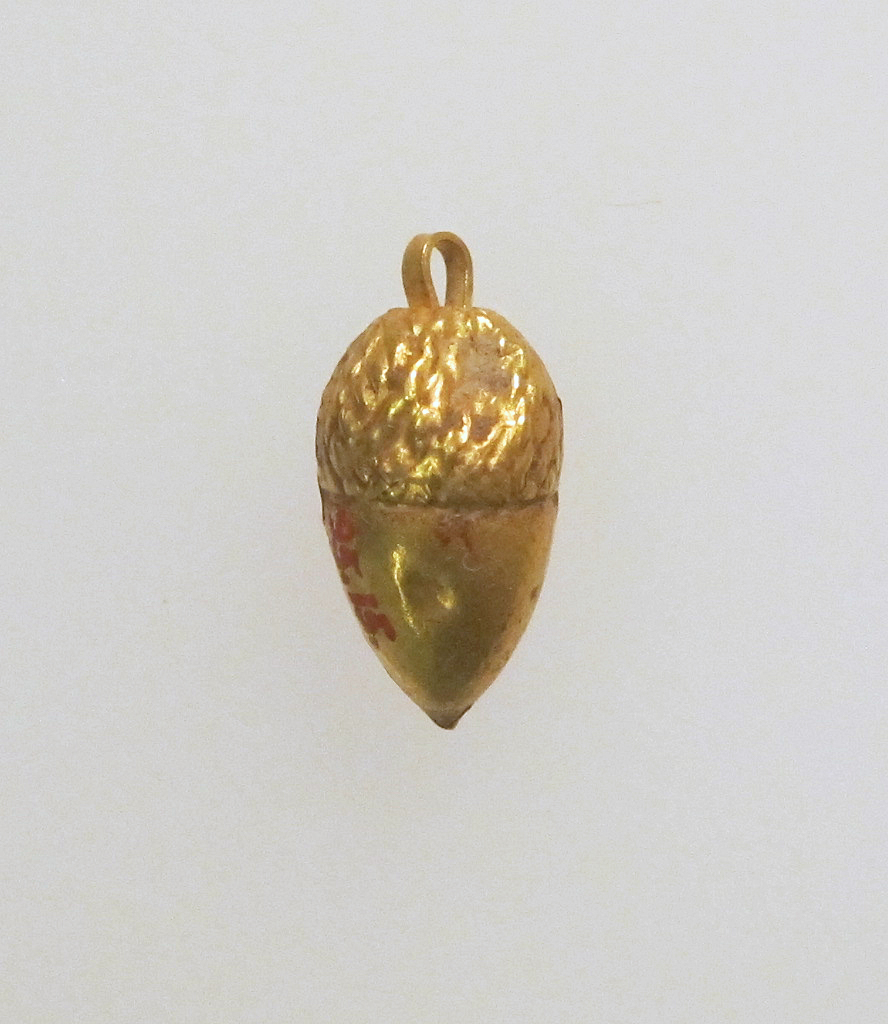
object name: pendant in the form of an acorn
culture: etruscan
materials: gold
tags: acorns